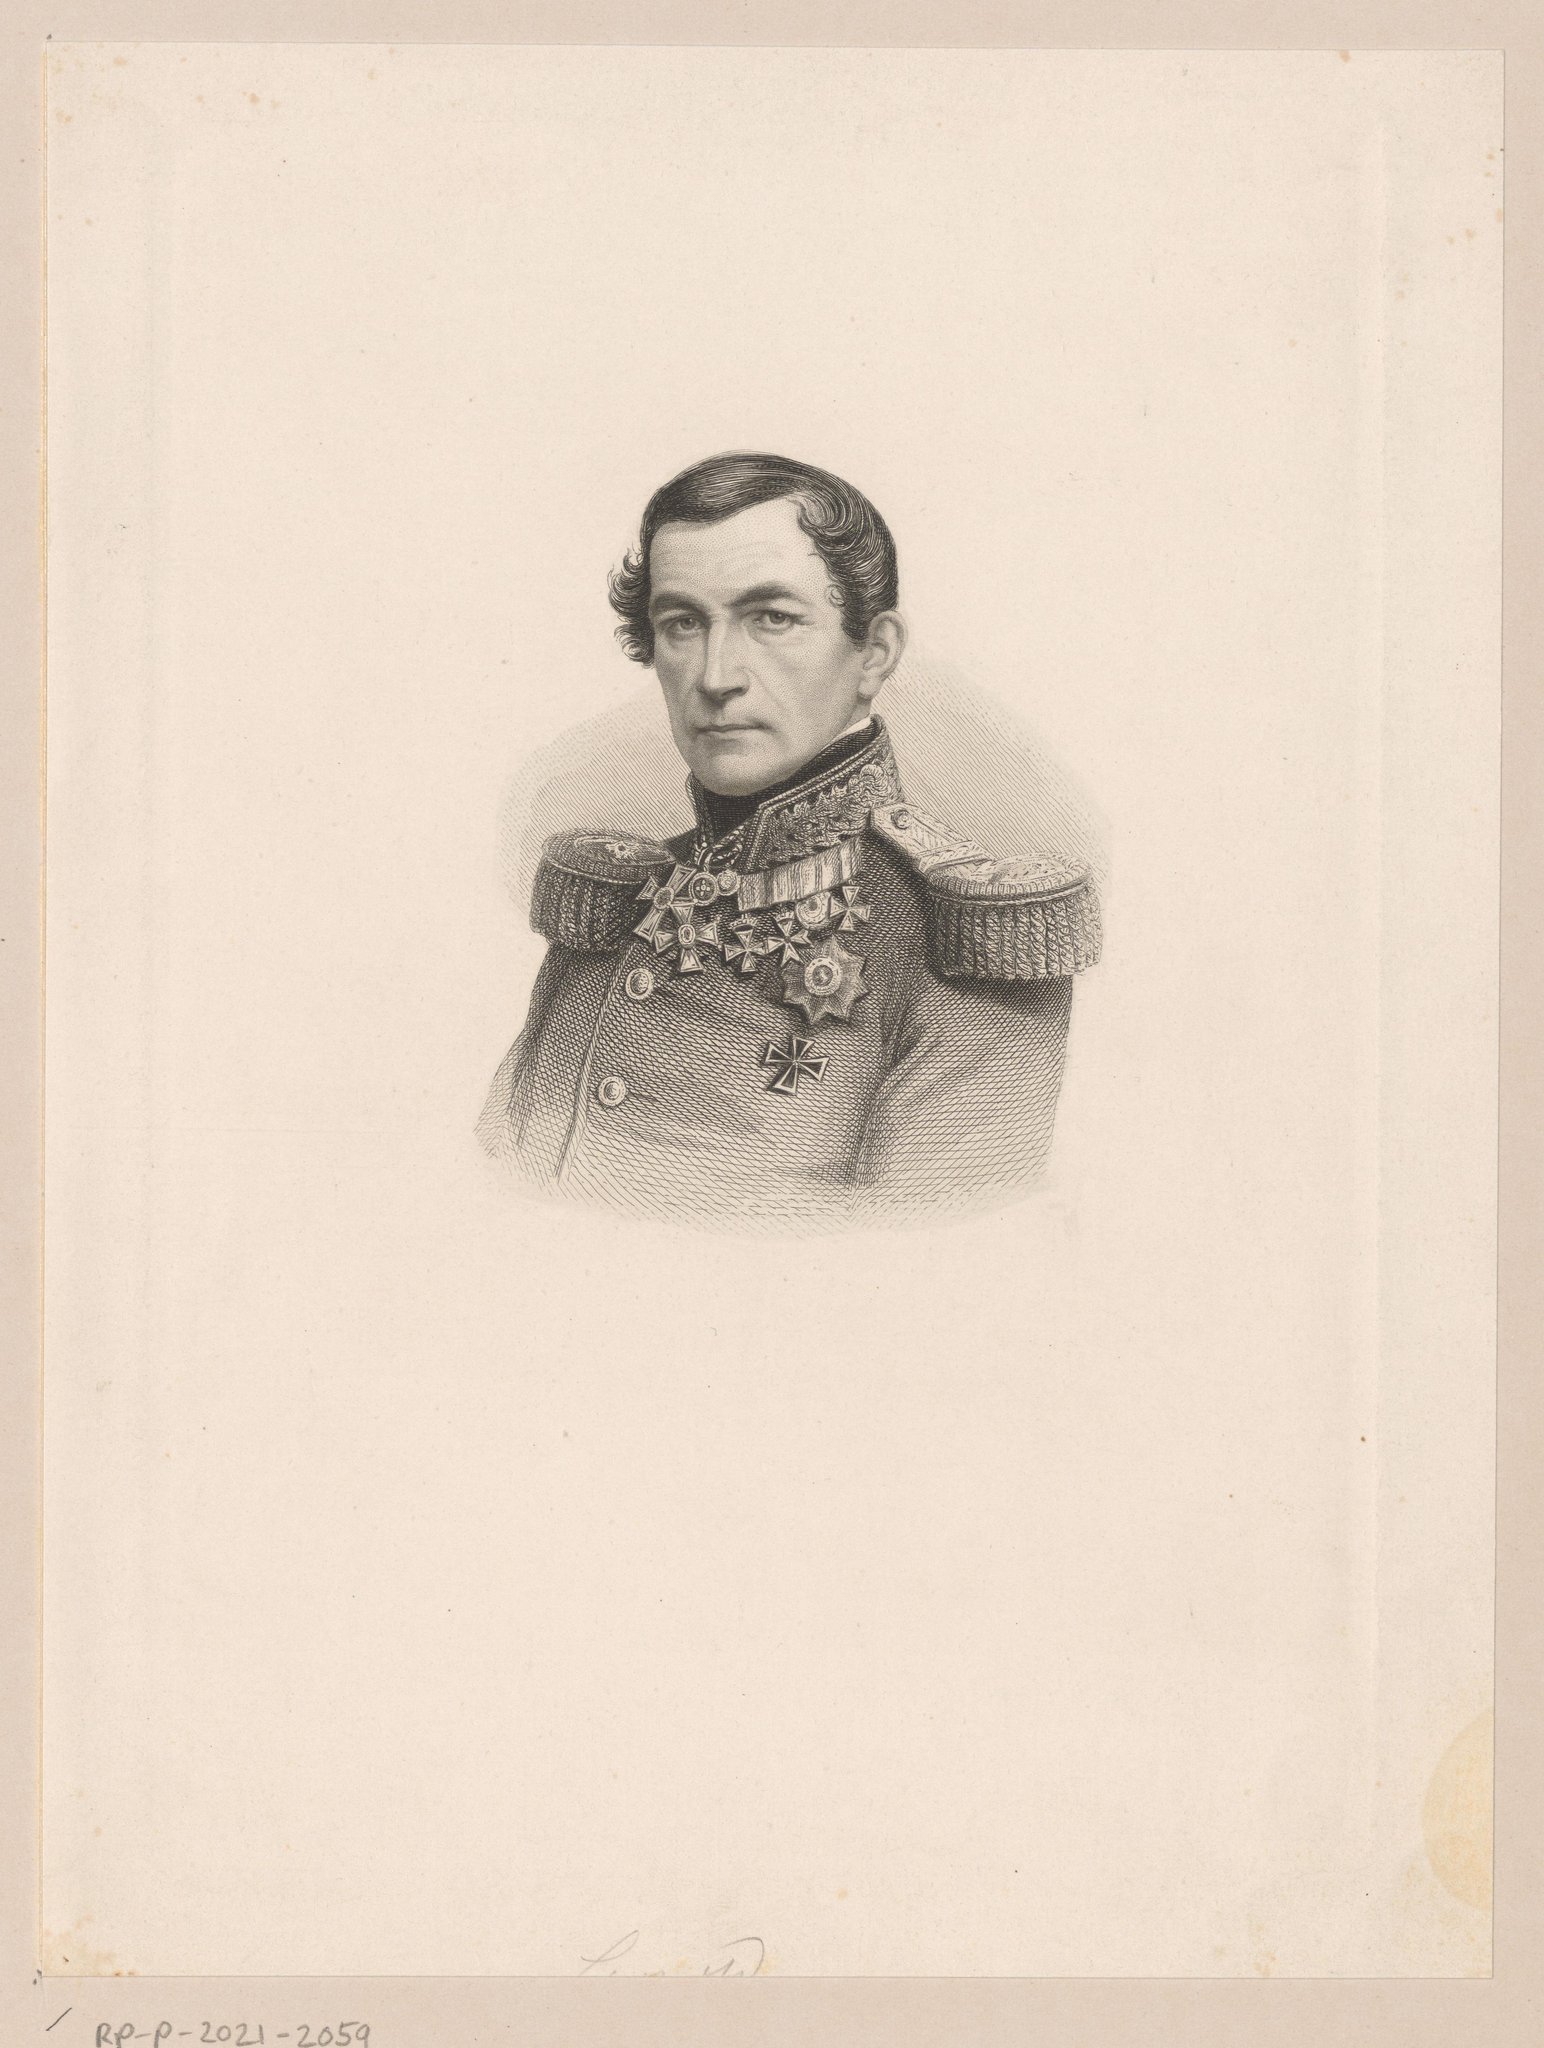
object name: print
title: Portret van Leopold I van België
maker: Anonymous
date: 1839-1865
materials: paper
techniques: engraving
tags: laeken, leopold i (koning der belgen), knighthood order, historical persons, (military) uniforms, king